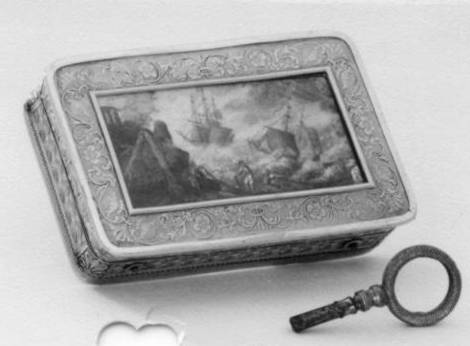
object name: music box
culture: swiss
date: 1810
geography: switzerland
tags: seascapes